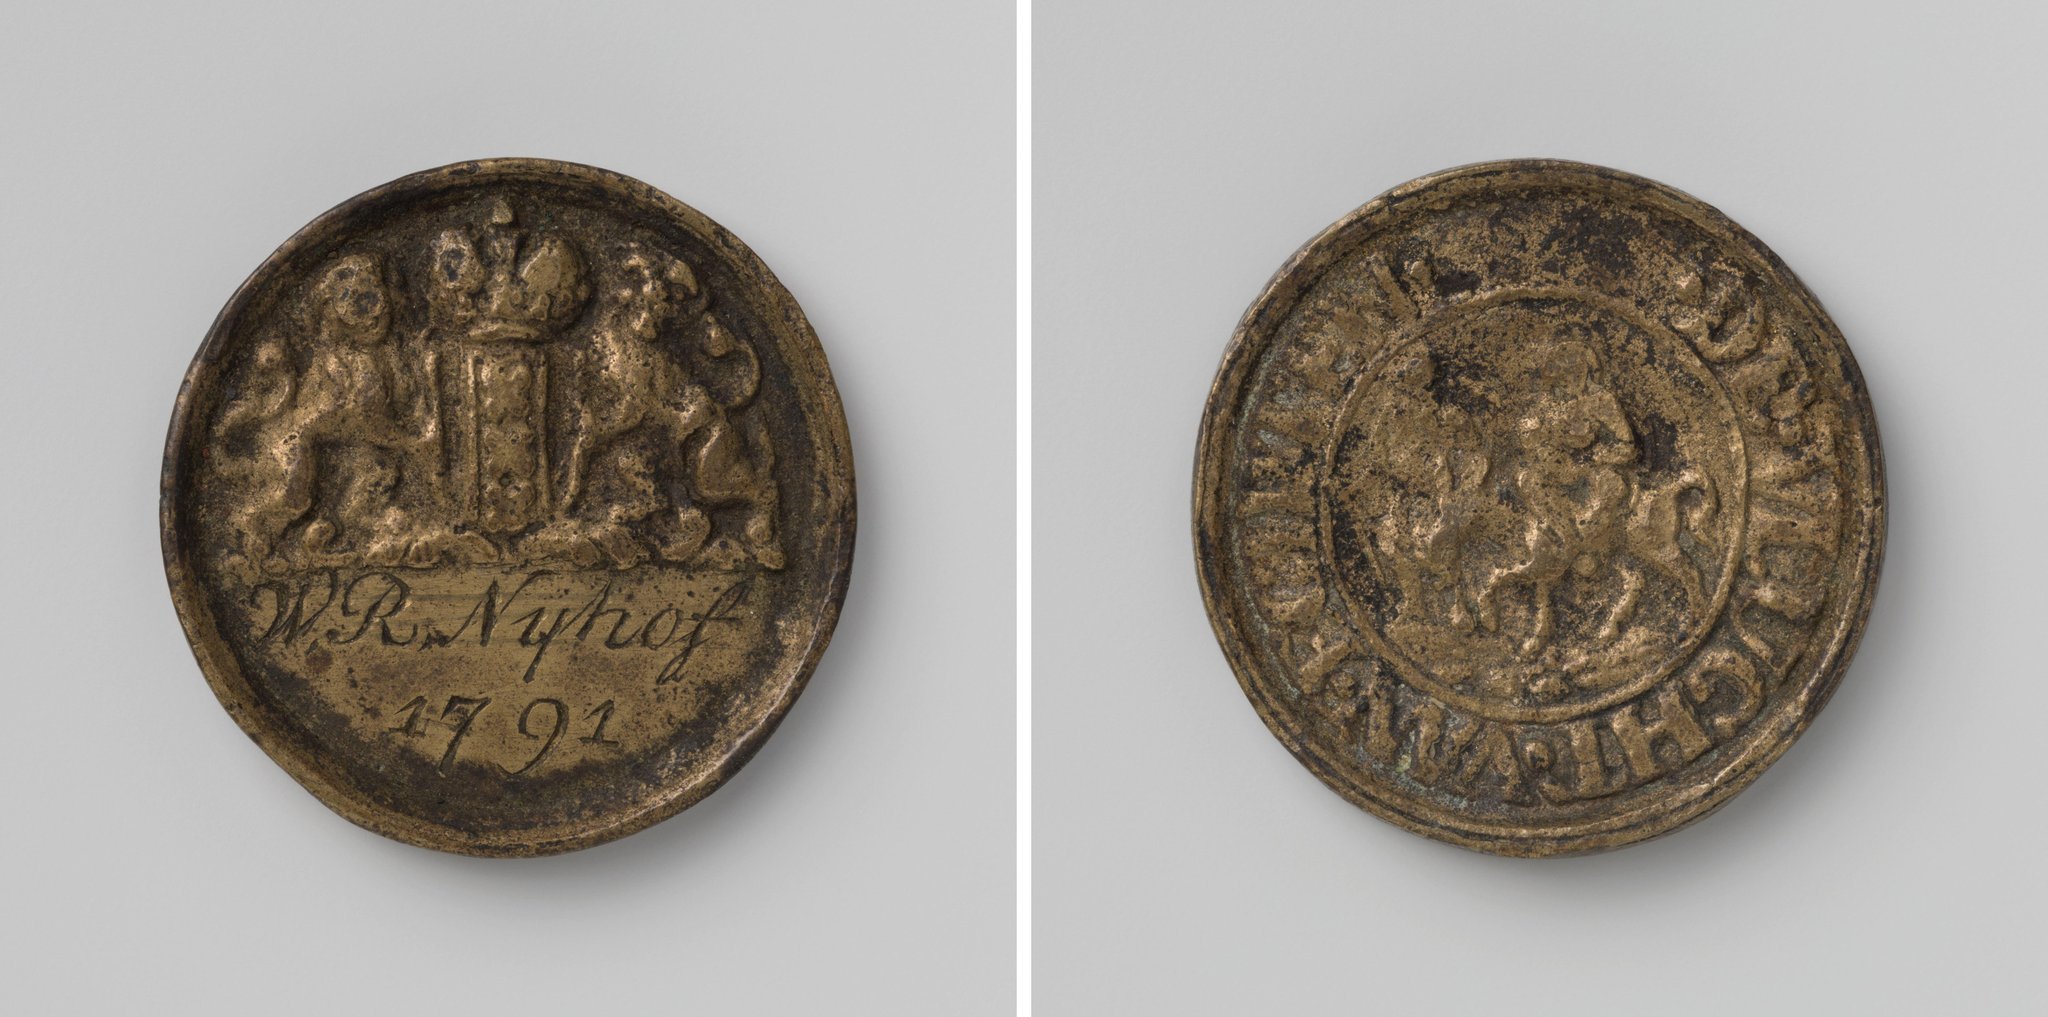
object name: medal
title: Timmerliedengilde van Amsterdam, gildepenning van W.R. Nijhof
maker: Anonymous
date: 1791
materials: brass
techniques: casting, engraving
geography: amsterdam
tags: amsterdam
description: Messing penning. Voorzijde: gekroond wapenschild, geflankeerd door twee leeuwen; afsnede: opschrift. Keerzijde: Maria, zittend met kind op ezeltje, dat door Jozef geleid wordt binnen omschrift